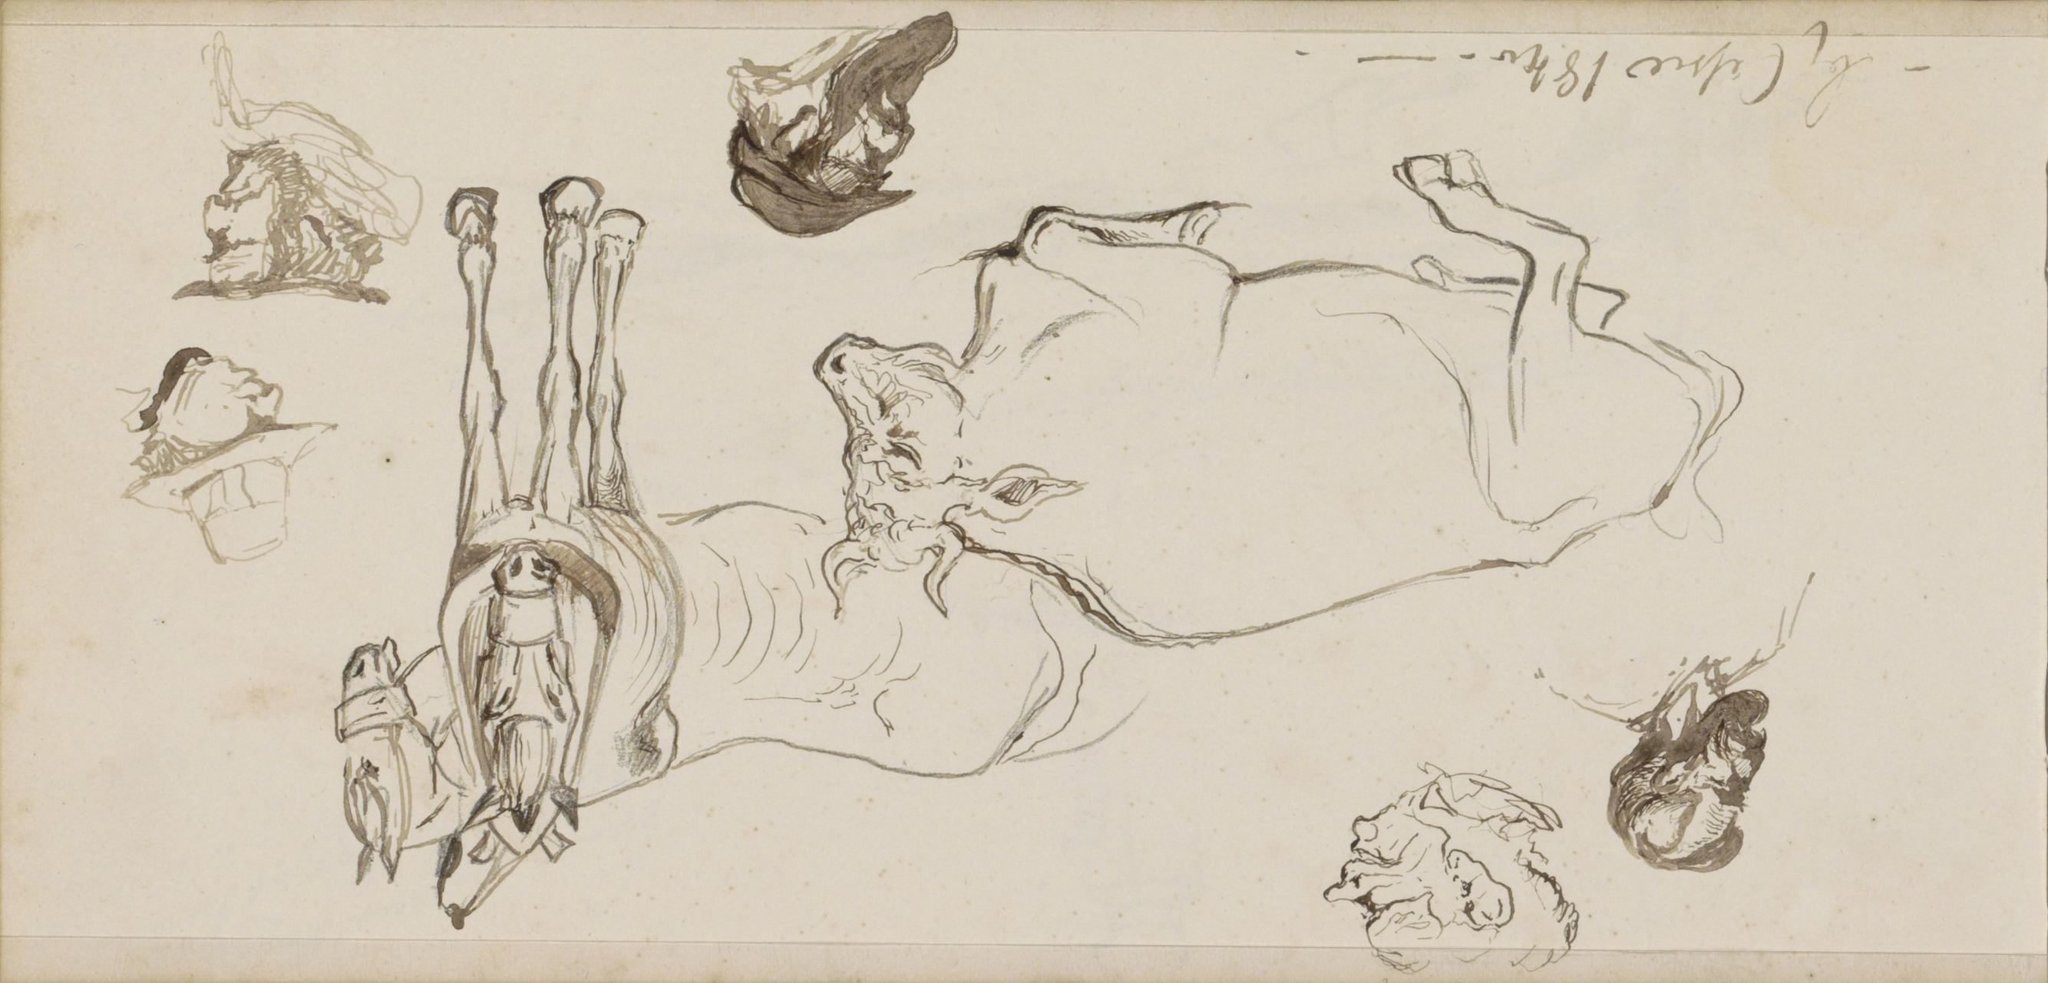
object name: sketchbook leaf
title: Mannenkoppen, koe en paarden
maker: johannes tavenraat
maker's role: draughtsman, painter, print maker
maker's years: 1809-1881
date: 1840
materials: ink, paper, pencil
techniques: pen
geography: kassel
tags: head (human), cow, adult man, horse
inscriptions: date and inscription: ‘bij Cassel 1840-’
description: Blad 44 verso uit een schetsboek met 63 bladen.